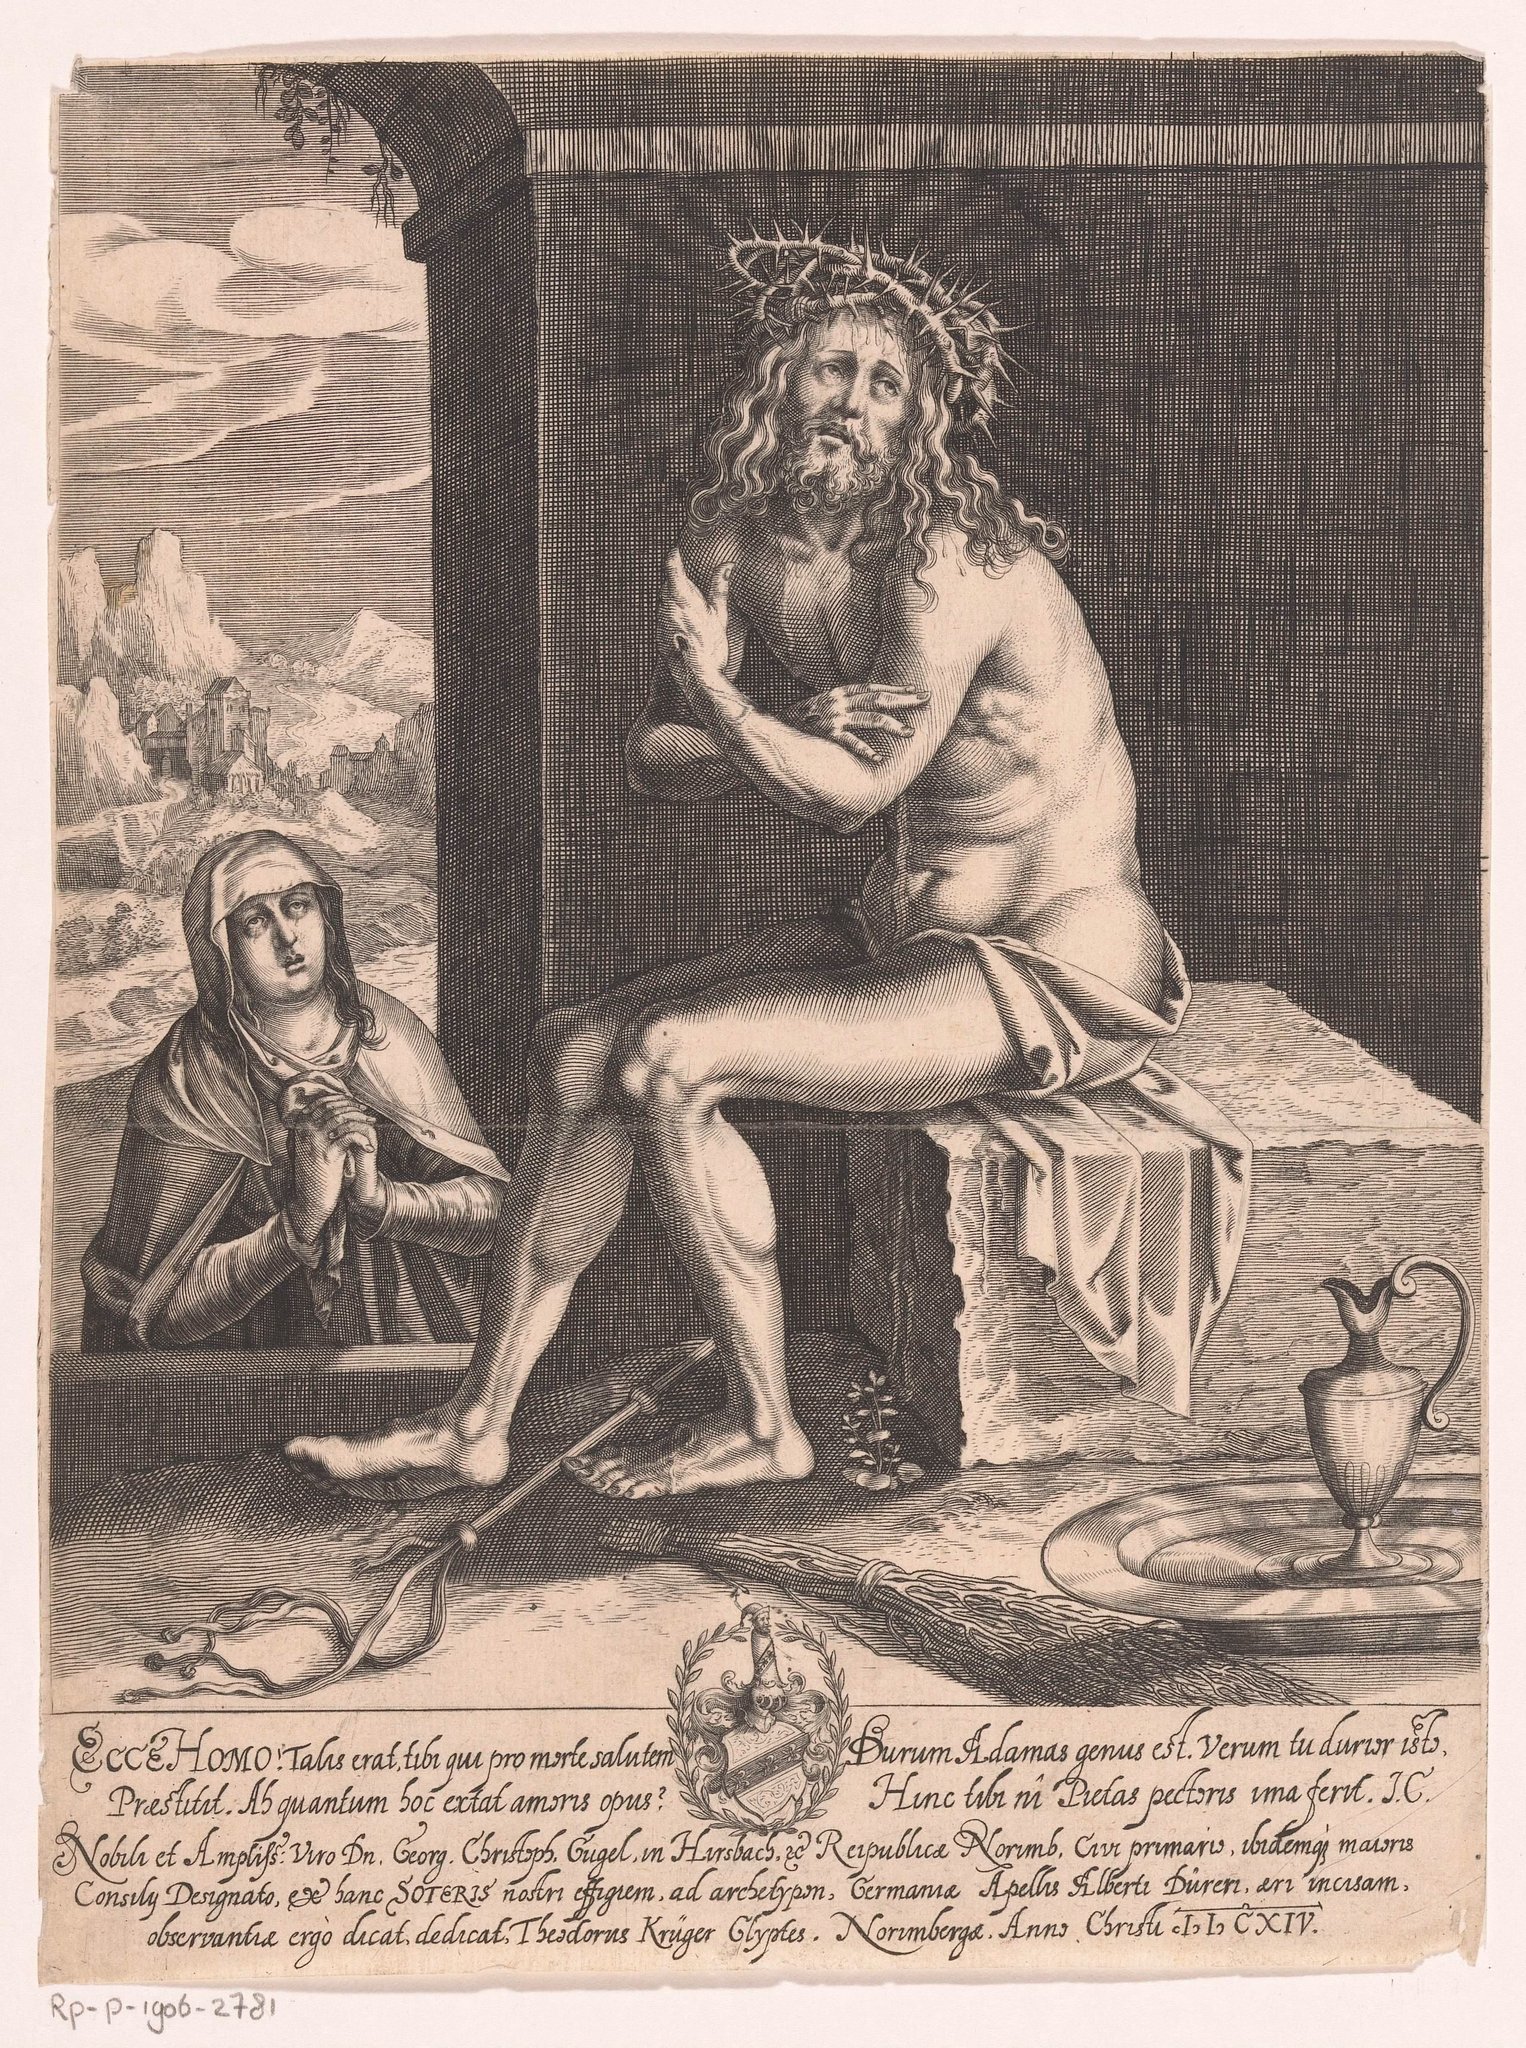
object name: print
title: Christus als Man van Smarten, vergezeld door Maria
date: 1614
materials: paper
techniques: engraving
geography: hirschbach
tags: man of sorrows together with others, single instruments of the passion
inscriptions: collector's mark: Lugt 2228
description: Met het wapenschild van de Duitse familie Gugel.